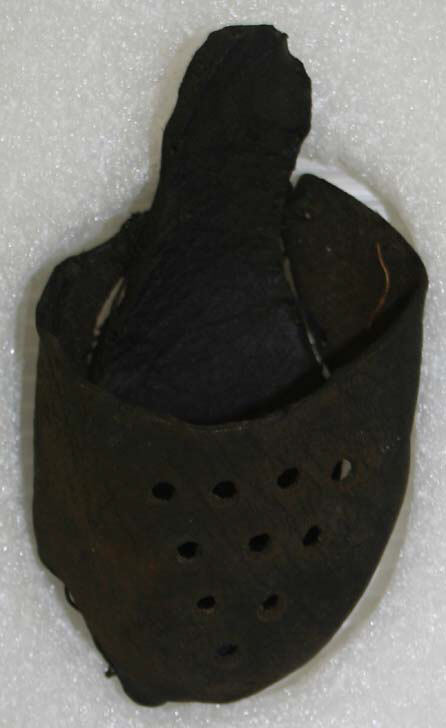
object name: shoe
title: Shoes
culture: british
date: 1601-1700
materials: leather